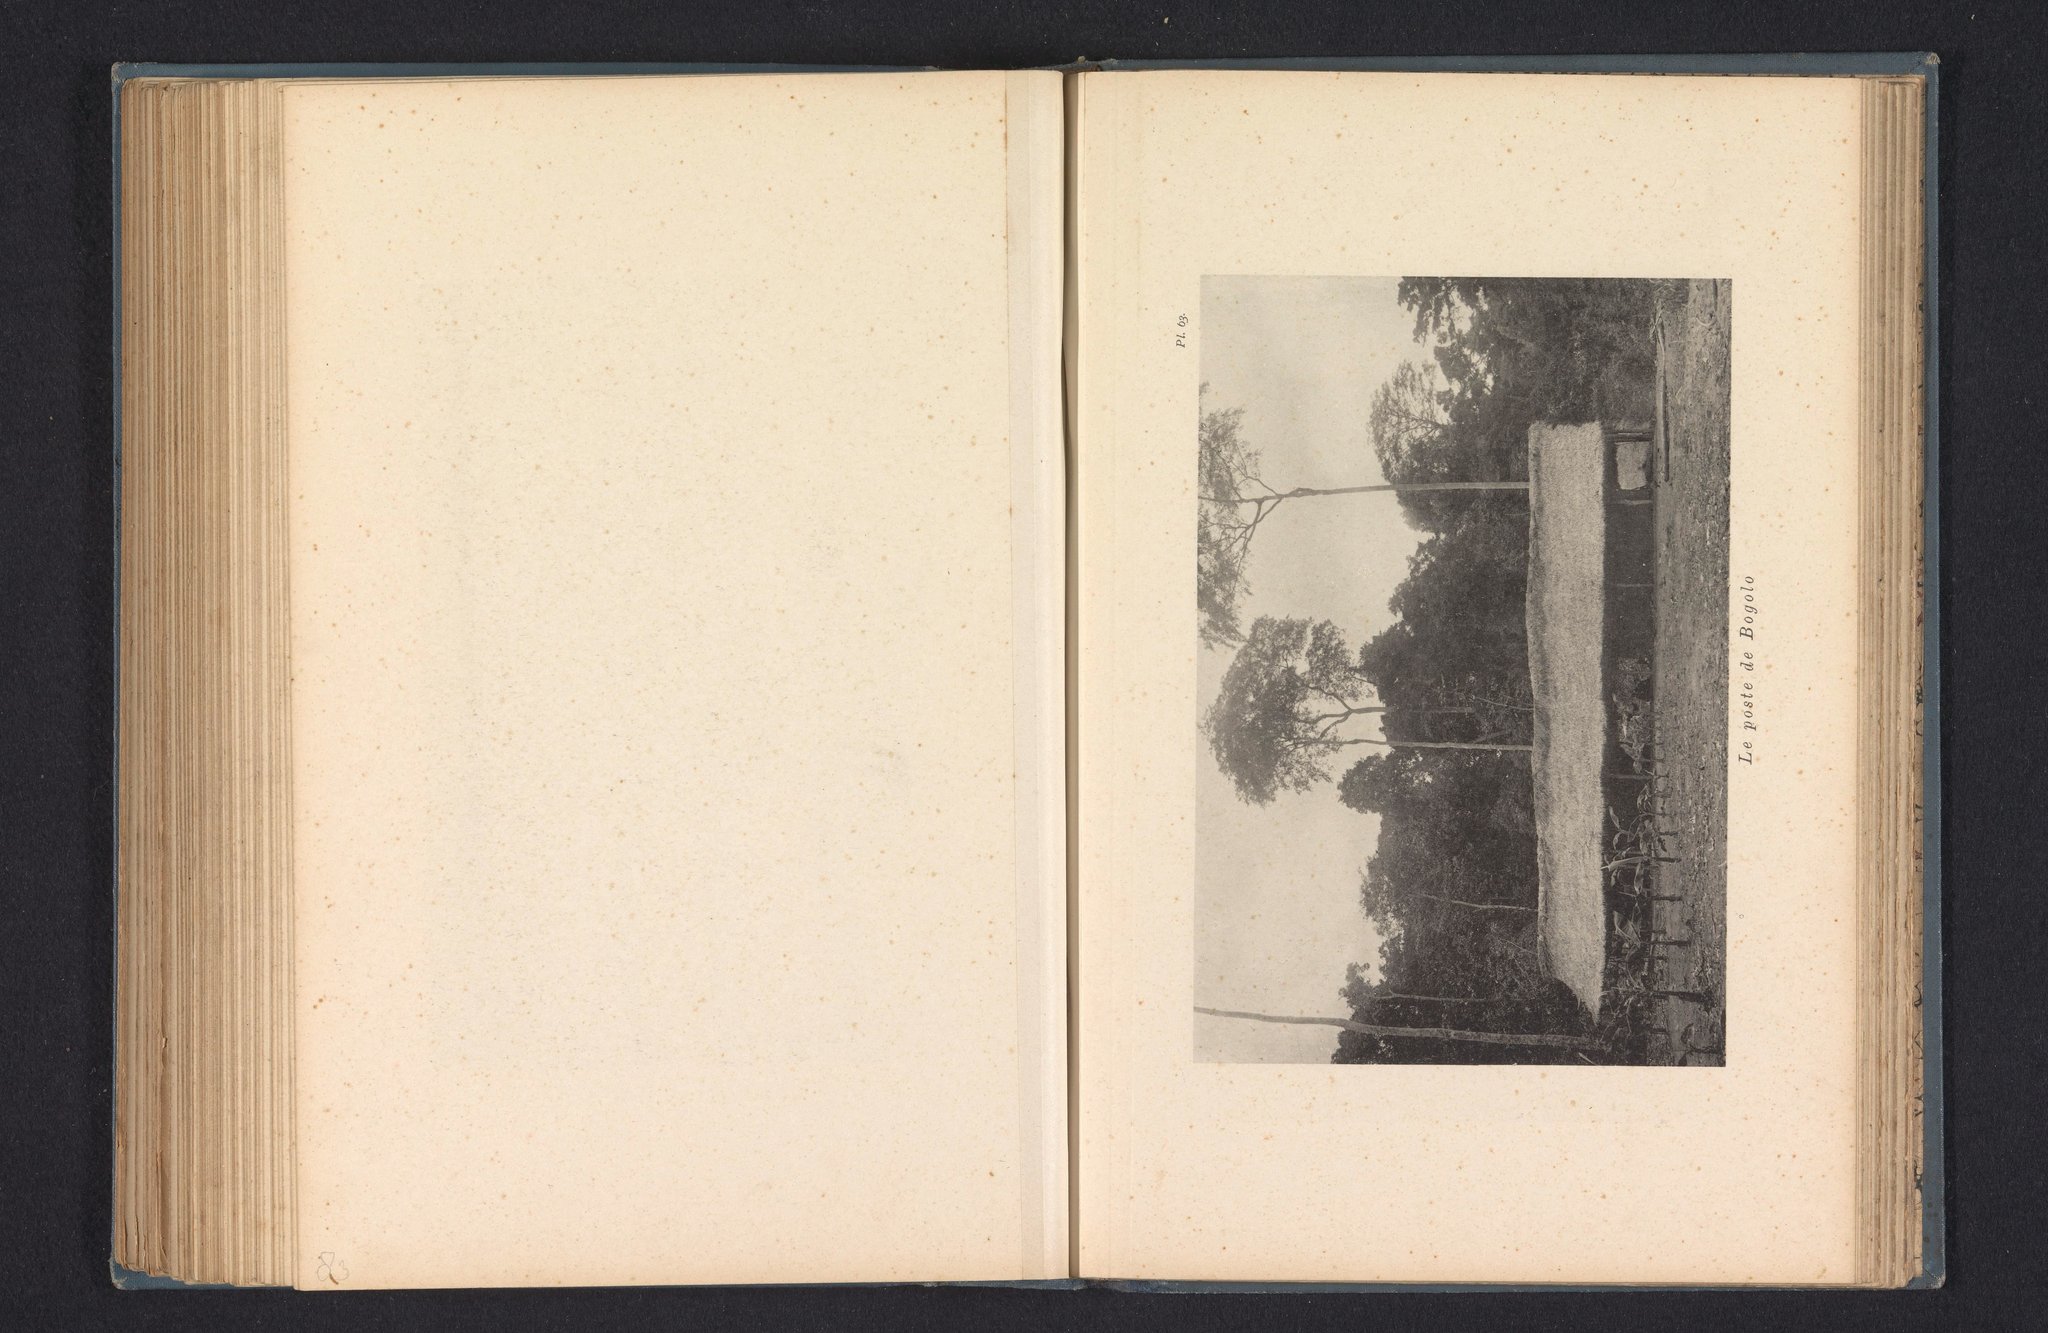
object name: page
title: Le poste de Bogolo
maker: franz thonner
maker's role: botanicus, ontdekkingsreiziger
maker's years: 1863-1928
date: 1896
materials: paper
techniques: photograph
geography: congo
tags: post-office, façade (of house or building)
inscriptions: number: ‘Pl. 63.’